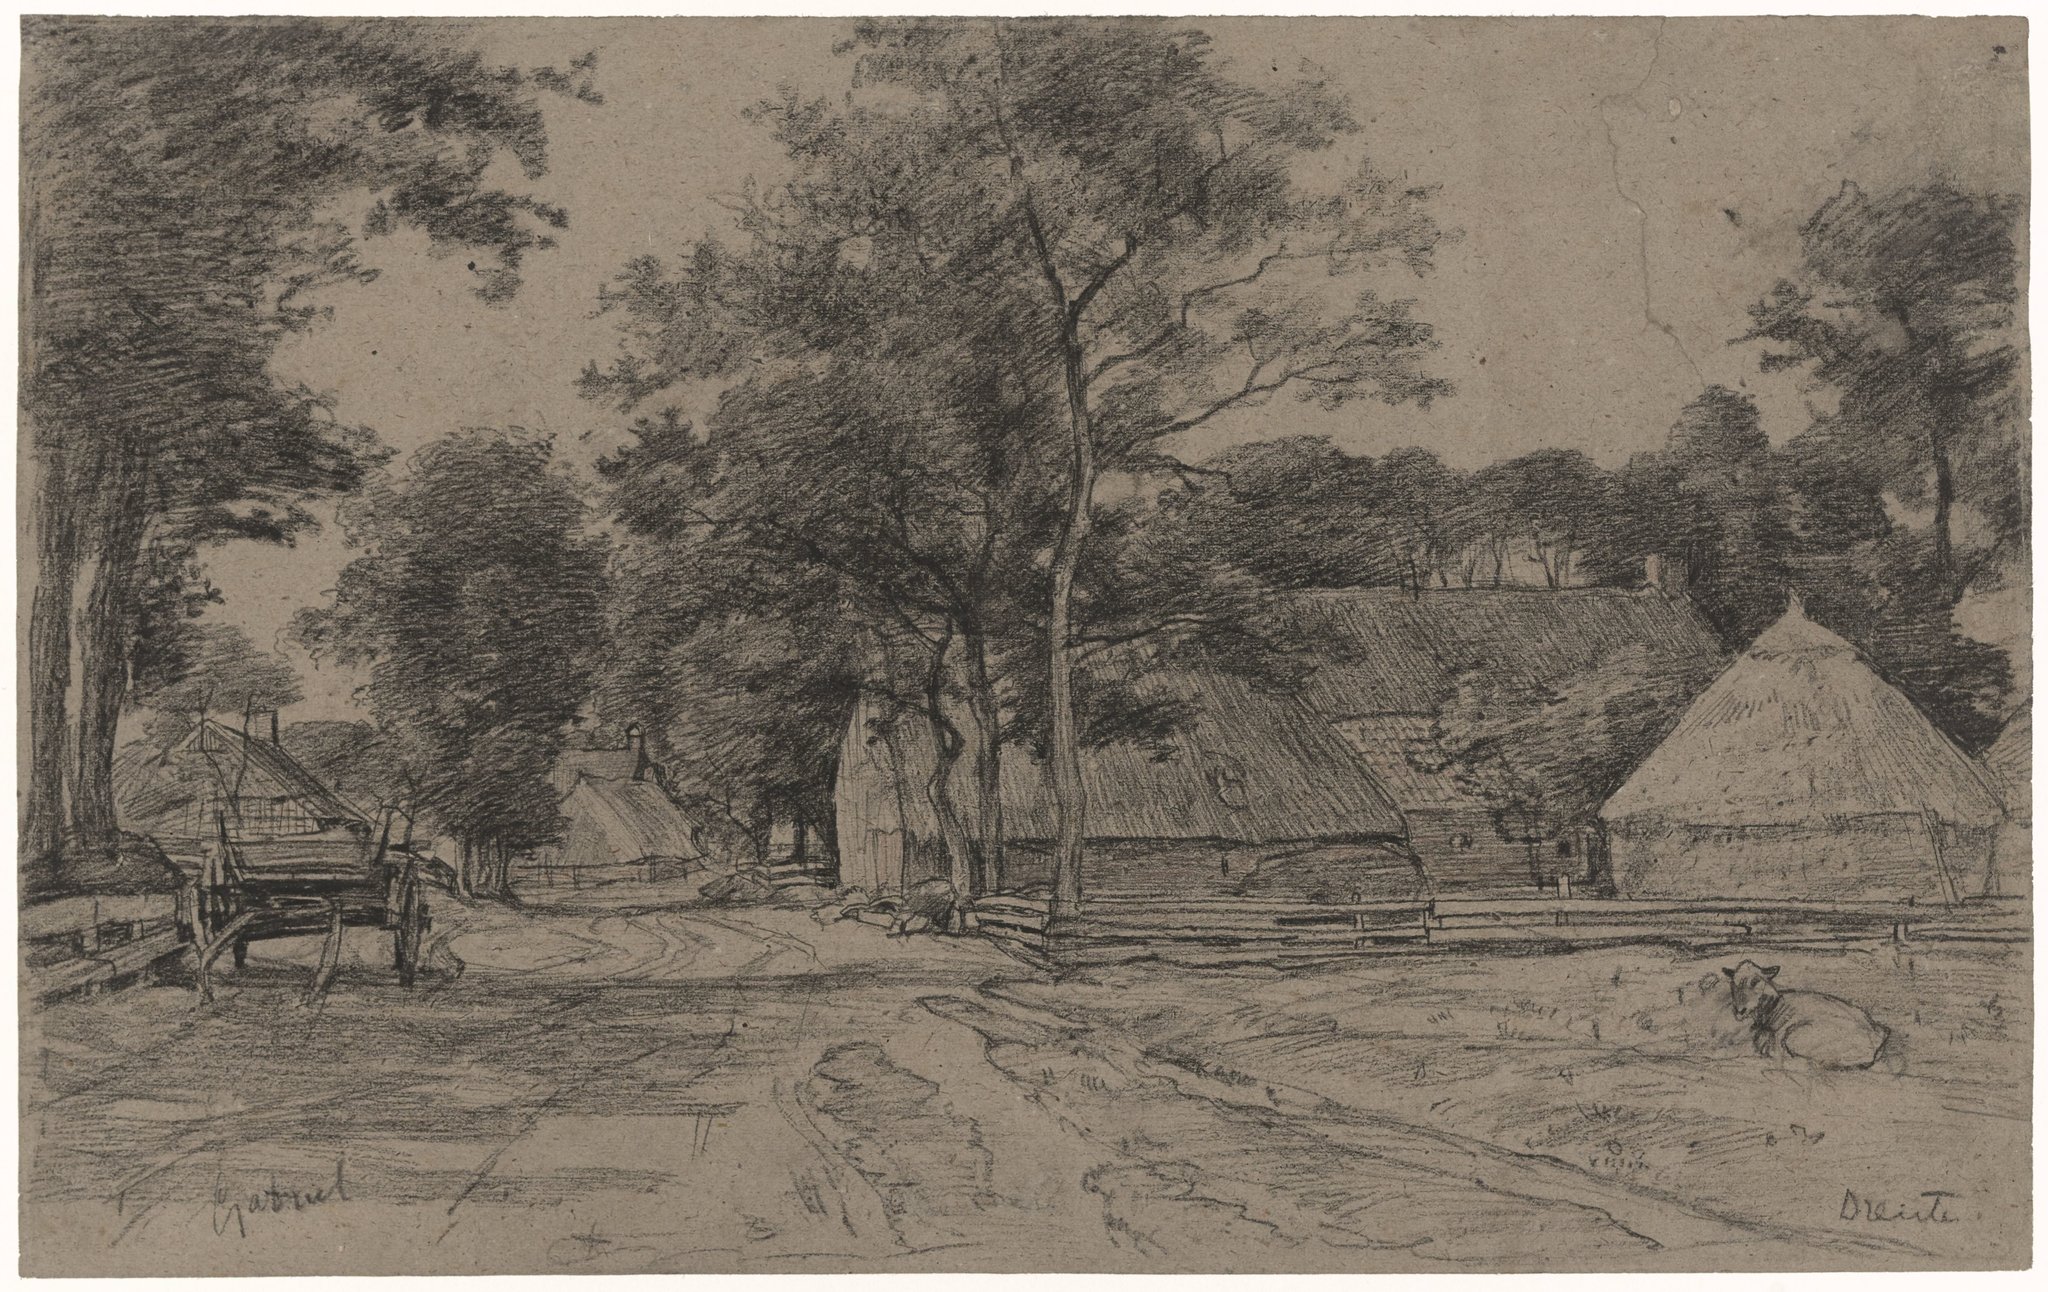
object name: drawing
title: Gezicht in een Drents dorp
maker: paul joseph constantin gabriël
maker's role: draughtsman, print maker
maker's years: 1828-1903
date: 1838-1903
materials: chalk, paper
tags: prospect of village, silhouette of village